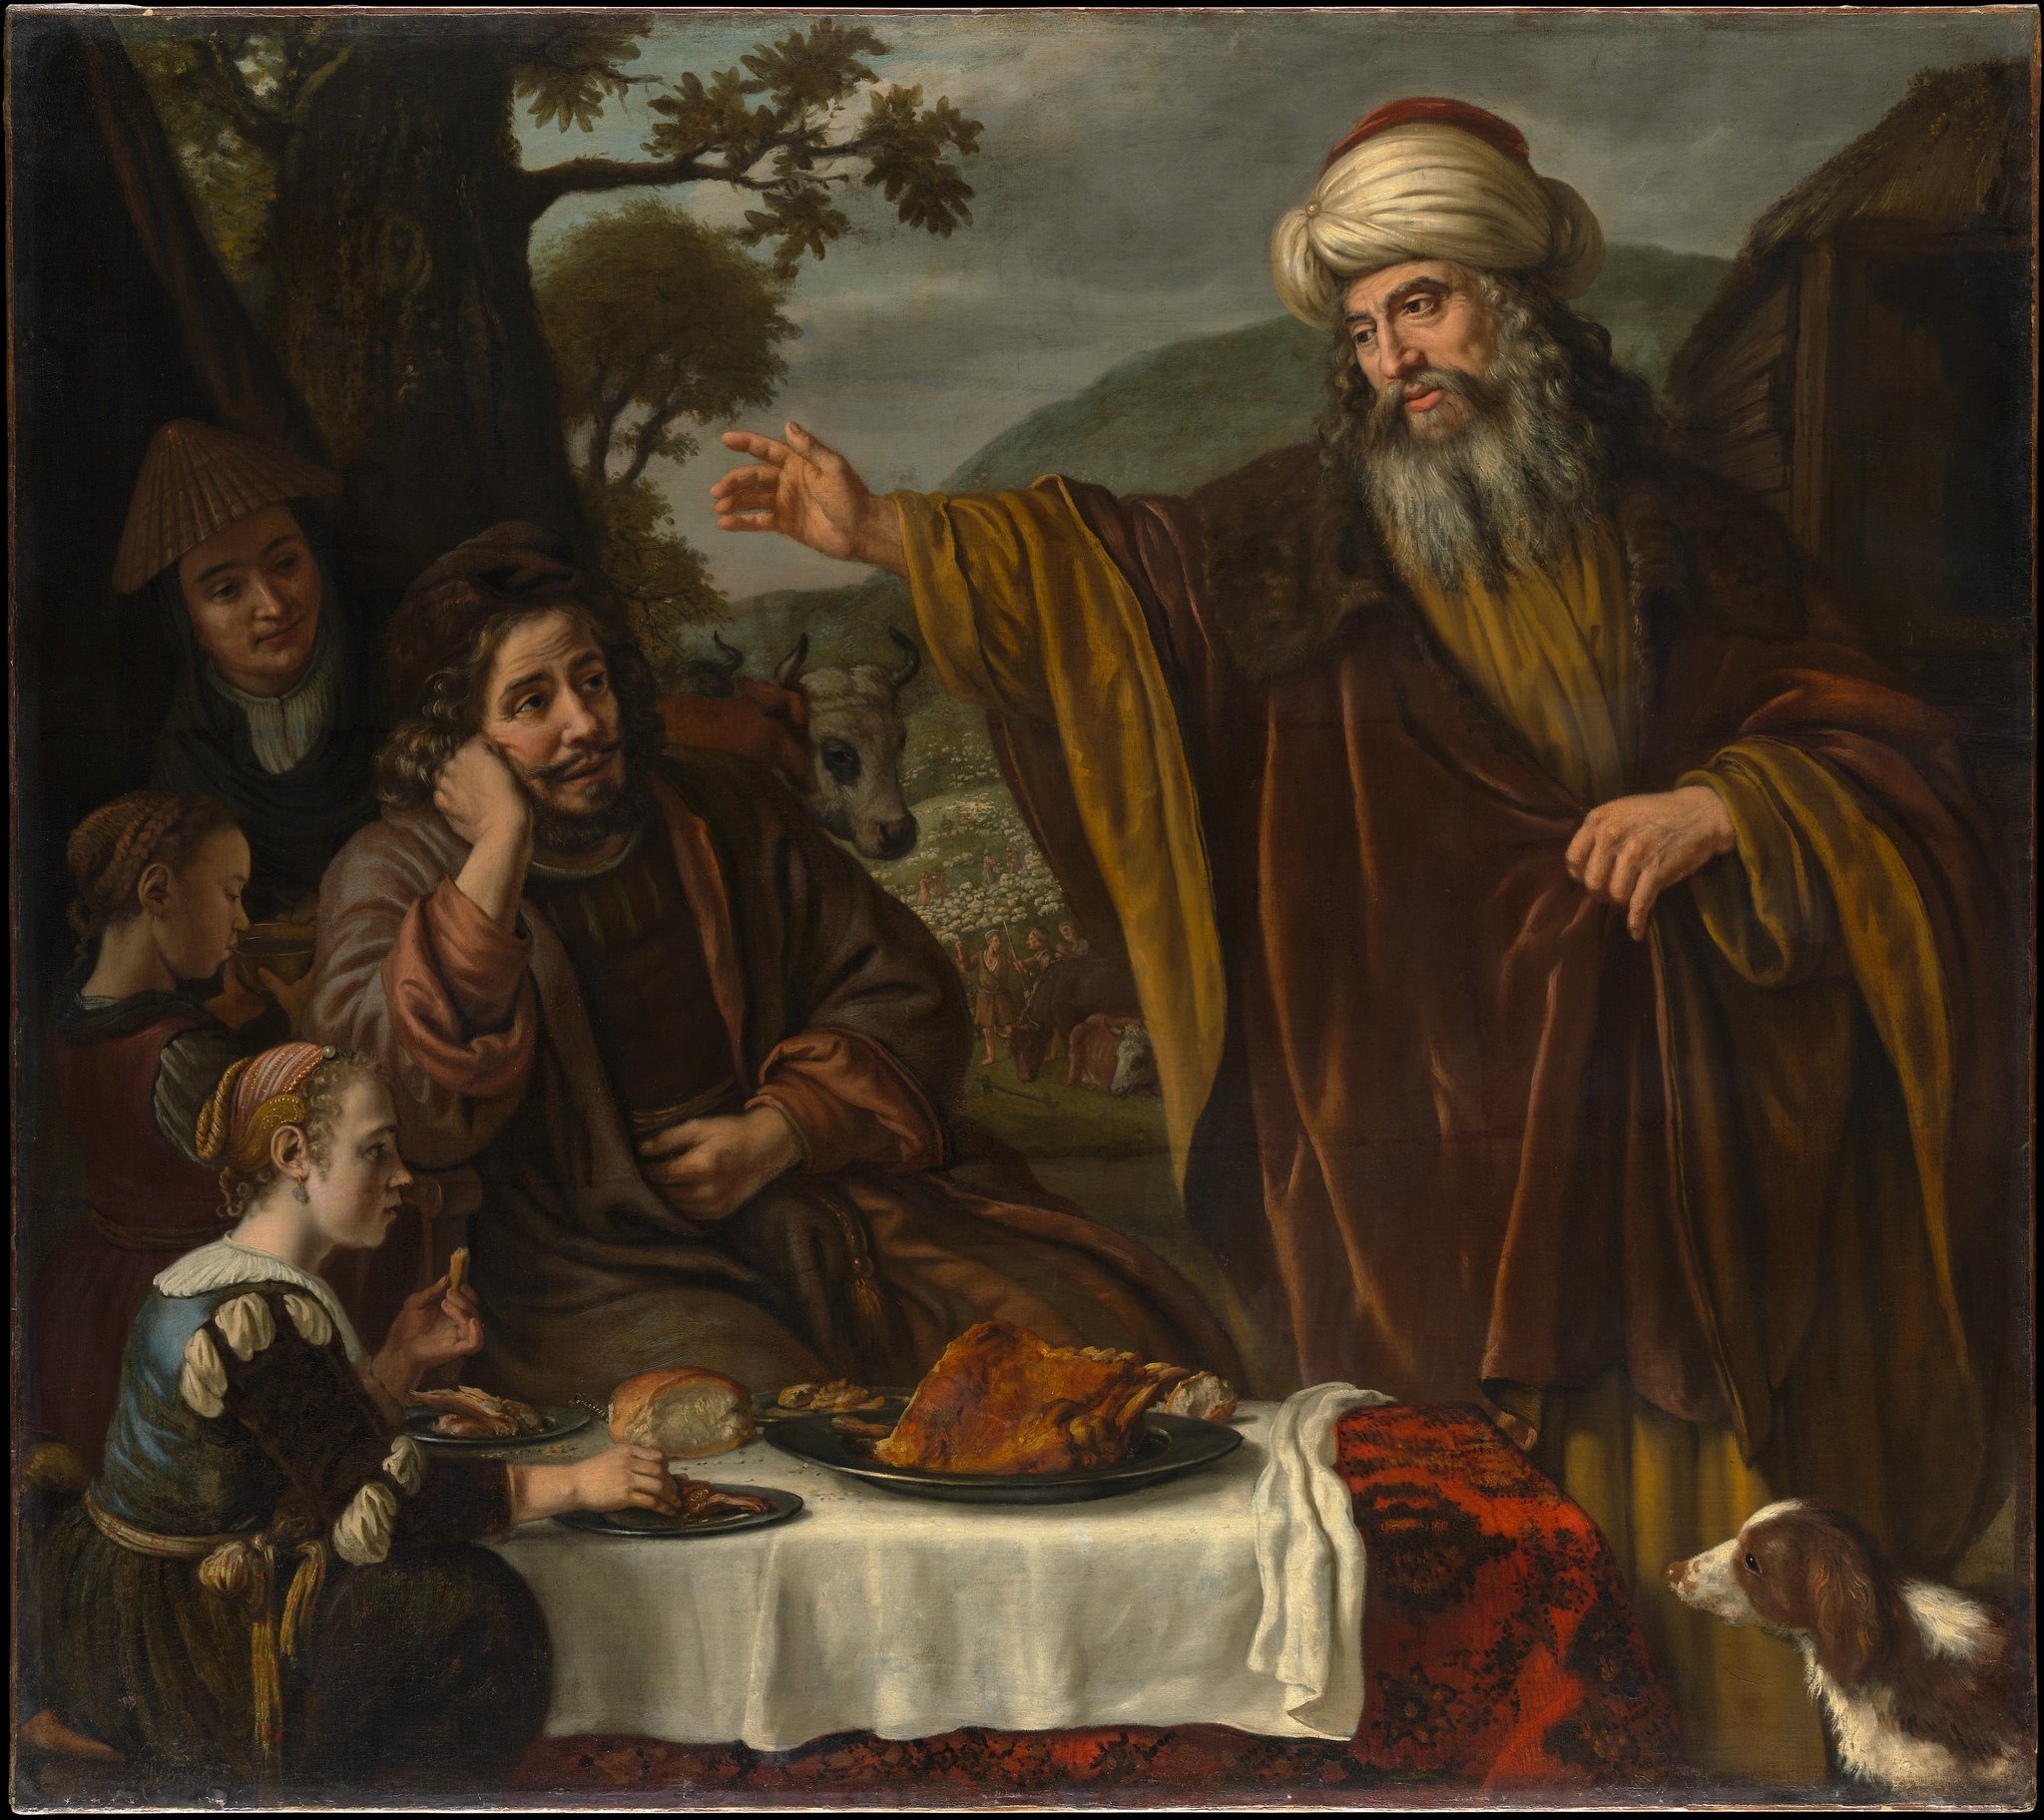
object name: painting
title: Abraham's Parting from the Family of Lot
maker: jan victors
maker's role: artist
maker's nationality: dutch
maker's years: 1619-1677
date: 1655-1665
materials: canvas, oil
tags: food,girls,men,women,dogs,abraham,eating